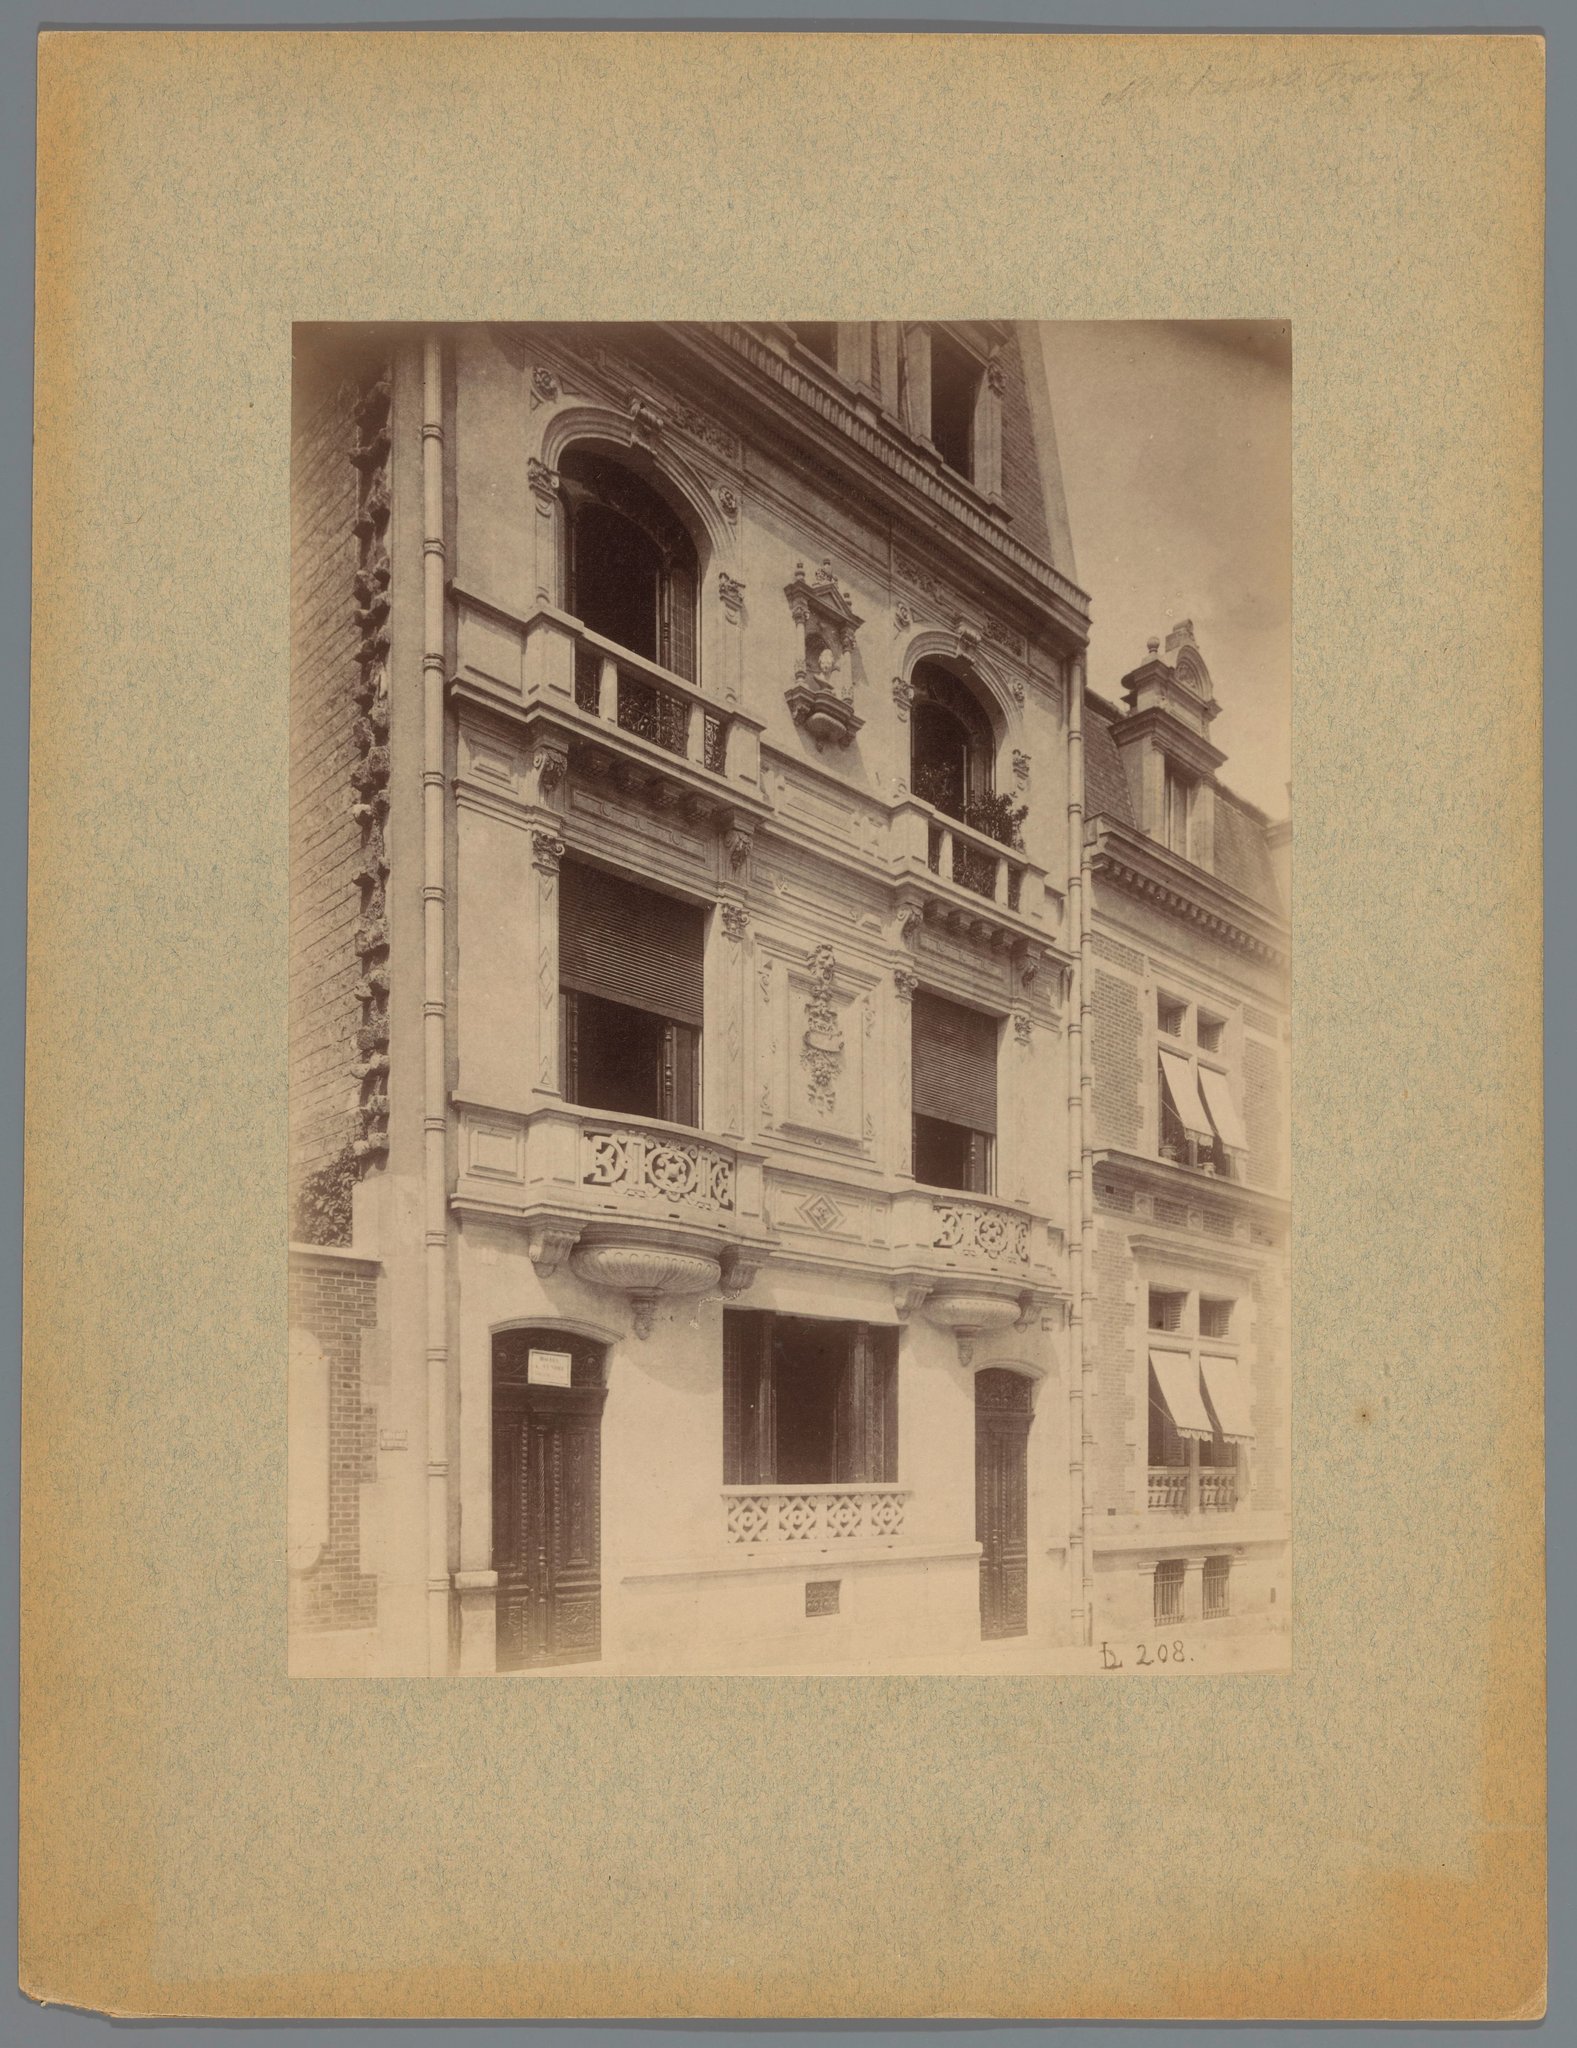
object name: photograph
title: Façade van een gebouw in Frankrijk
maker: Anonymous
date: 1875-1900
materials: cardboard, photographic support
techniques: albumen print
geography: france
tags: balcony, hôtel, i.e. small palace in city, façade (of house or building), france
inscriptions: inscription: ‘Mod Bouwk Frankrijk’, name: ‘KUNSTBOEKHANDEL J. A. G. DE LEUR PHOTOGRAAf - UITGEVER Huigenspark, 40b. DEN HAAG’, number: ‘[...]208.’, collector's mark: Lugt 3937